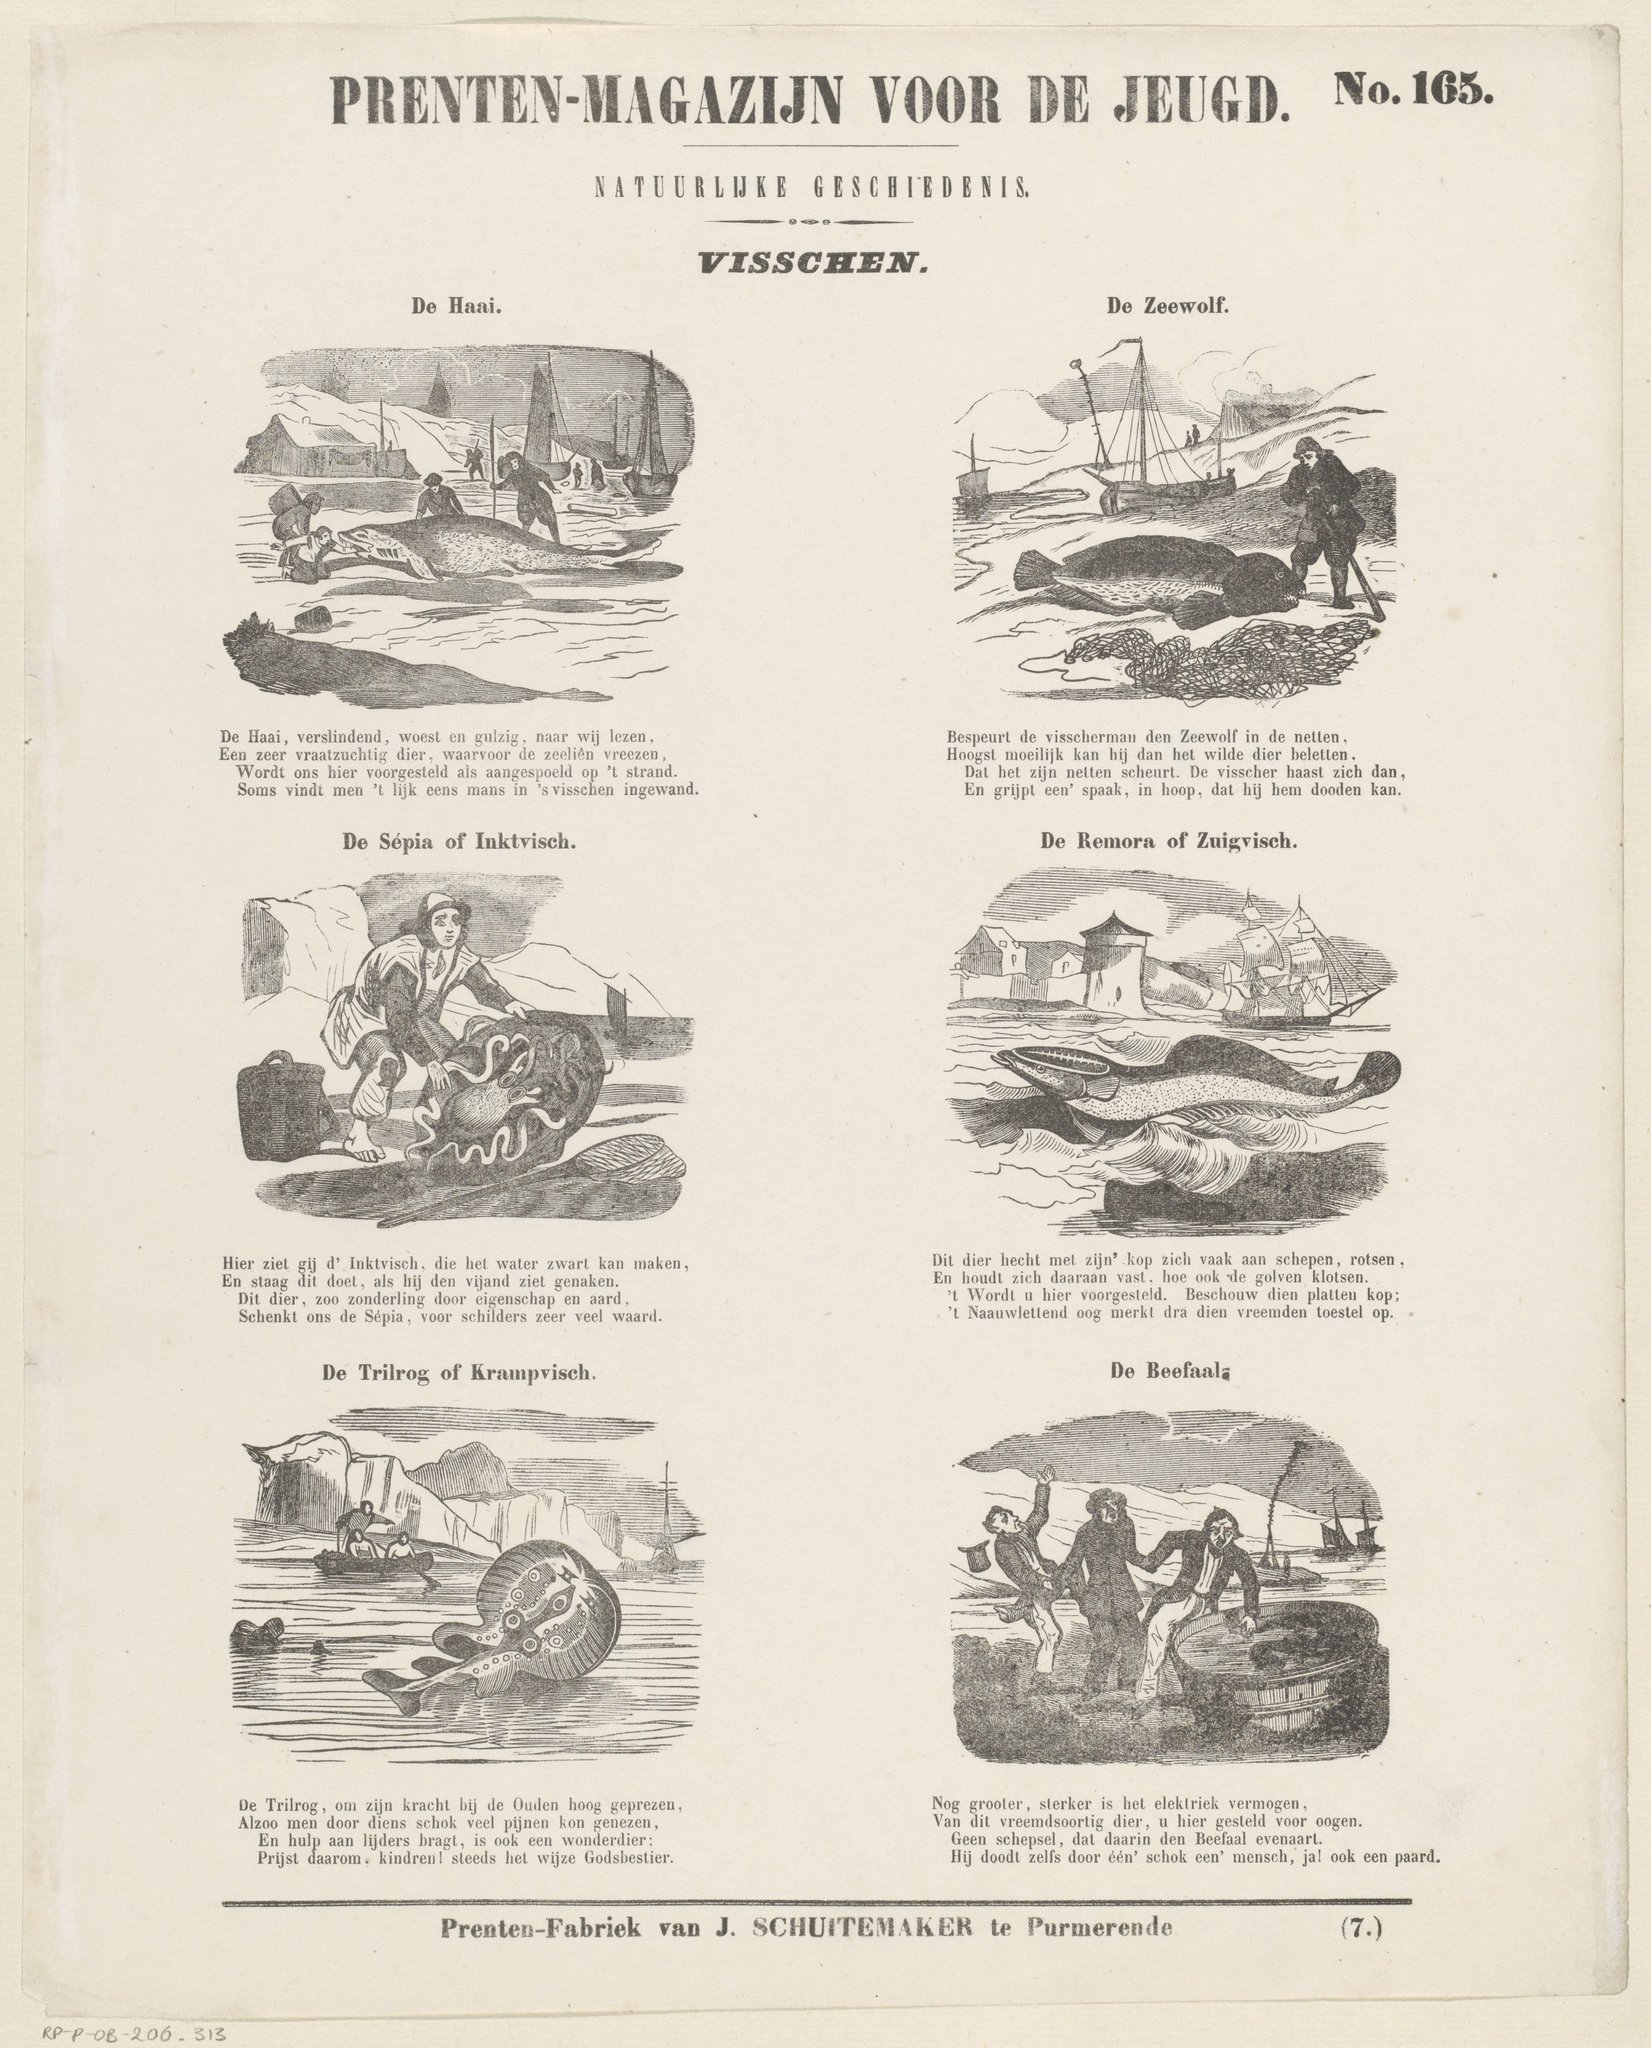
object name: popular print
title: Prenten-magazijn voor de jeugd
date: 1850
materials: paper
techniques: letterpress printing, engraving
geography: purmerend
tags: molluscs: squid, fishes, eels: eel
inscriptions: collector's mark: Lugt 2760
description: Na voltooiing van de acht jaargangen van de reeks 'Prenten-magazijn voor de jeugd' in 1850 heeft Jan Schuitemaker al deze prenten heruitgegeven en omgenummerd als nr. 1 t/m 192. De oorspronkelijke jaargang wordt telkens nog vermeld rechtsonder op de prent. Binnen de jaargangen zijn prenten van hetzelfde thema in clusters van vier achter elkaar gezet.